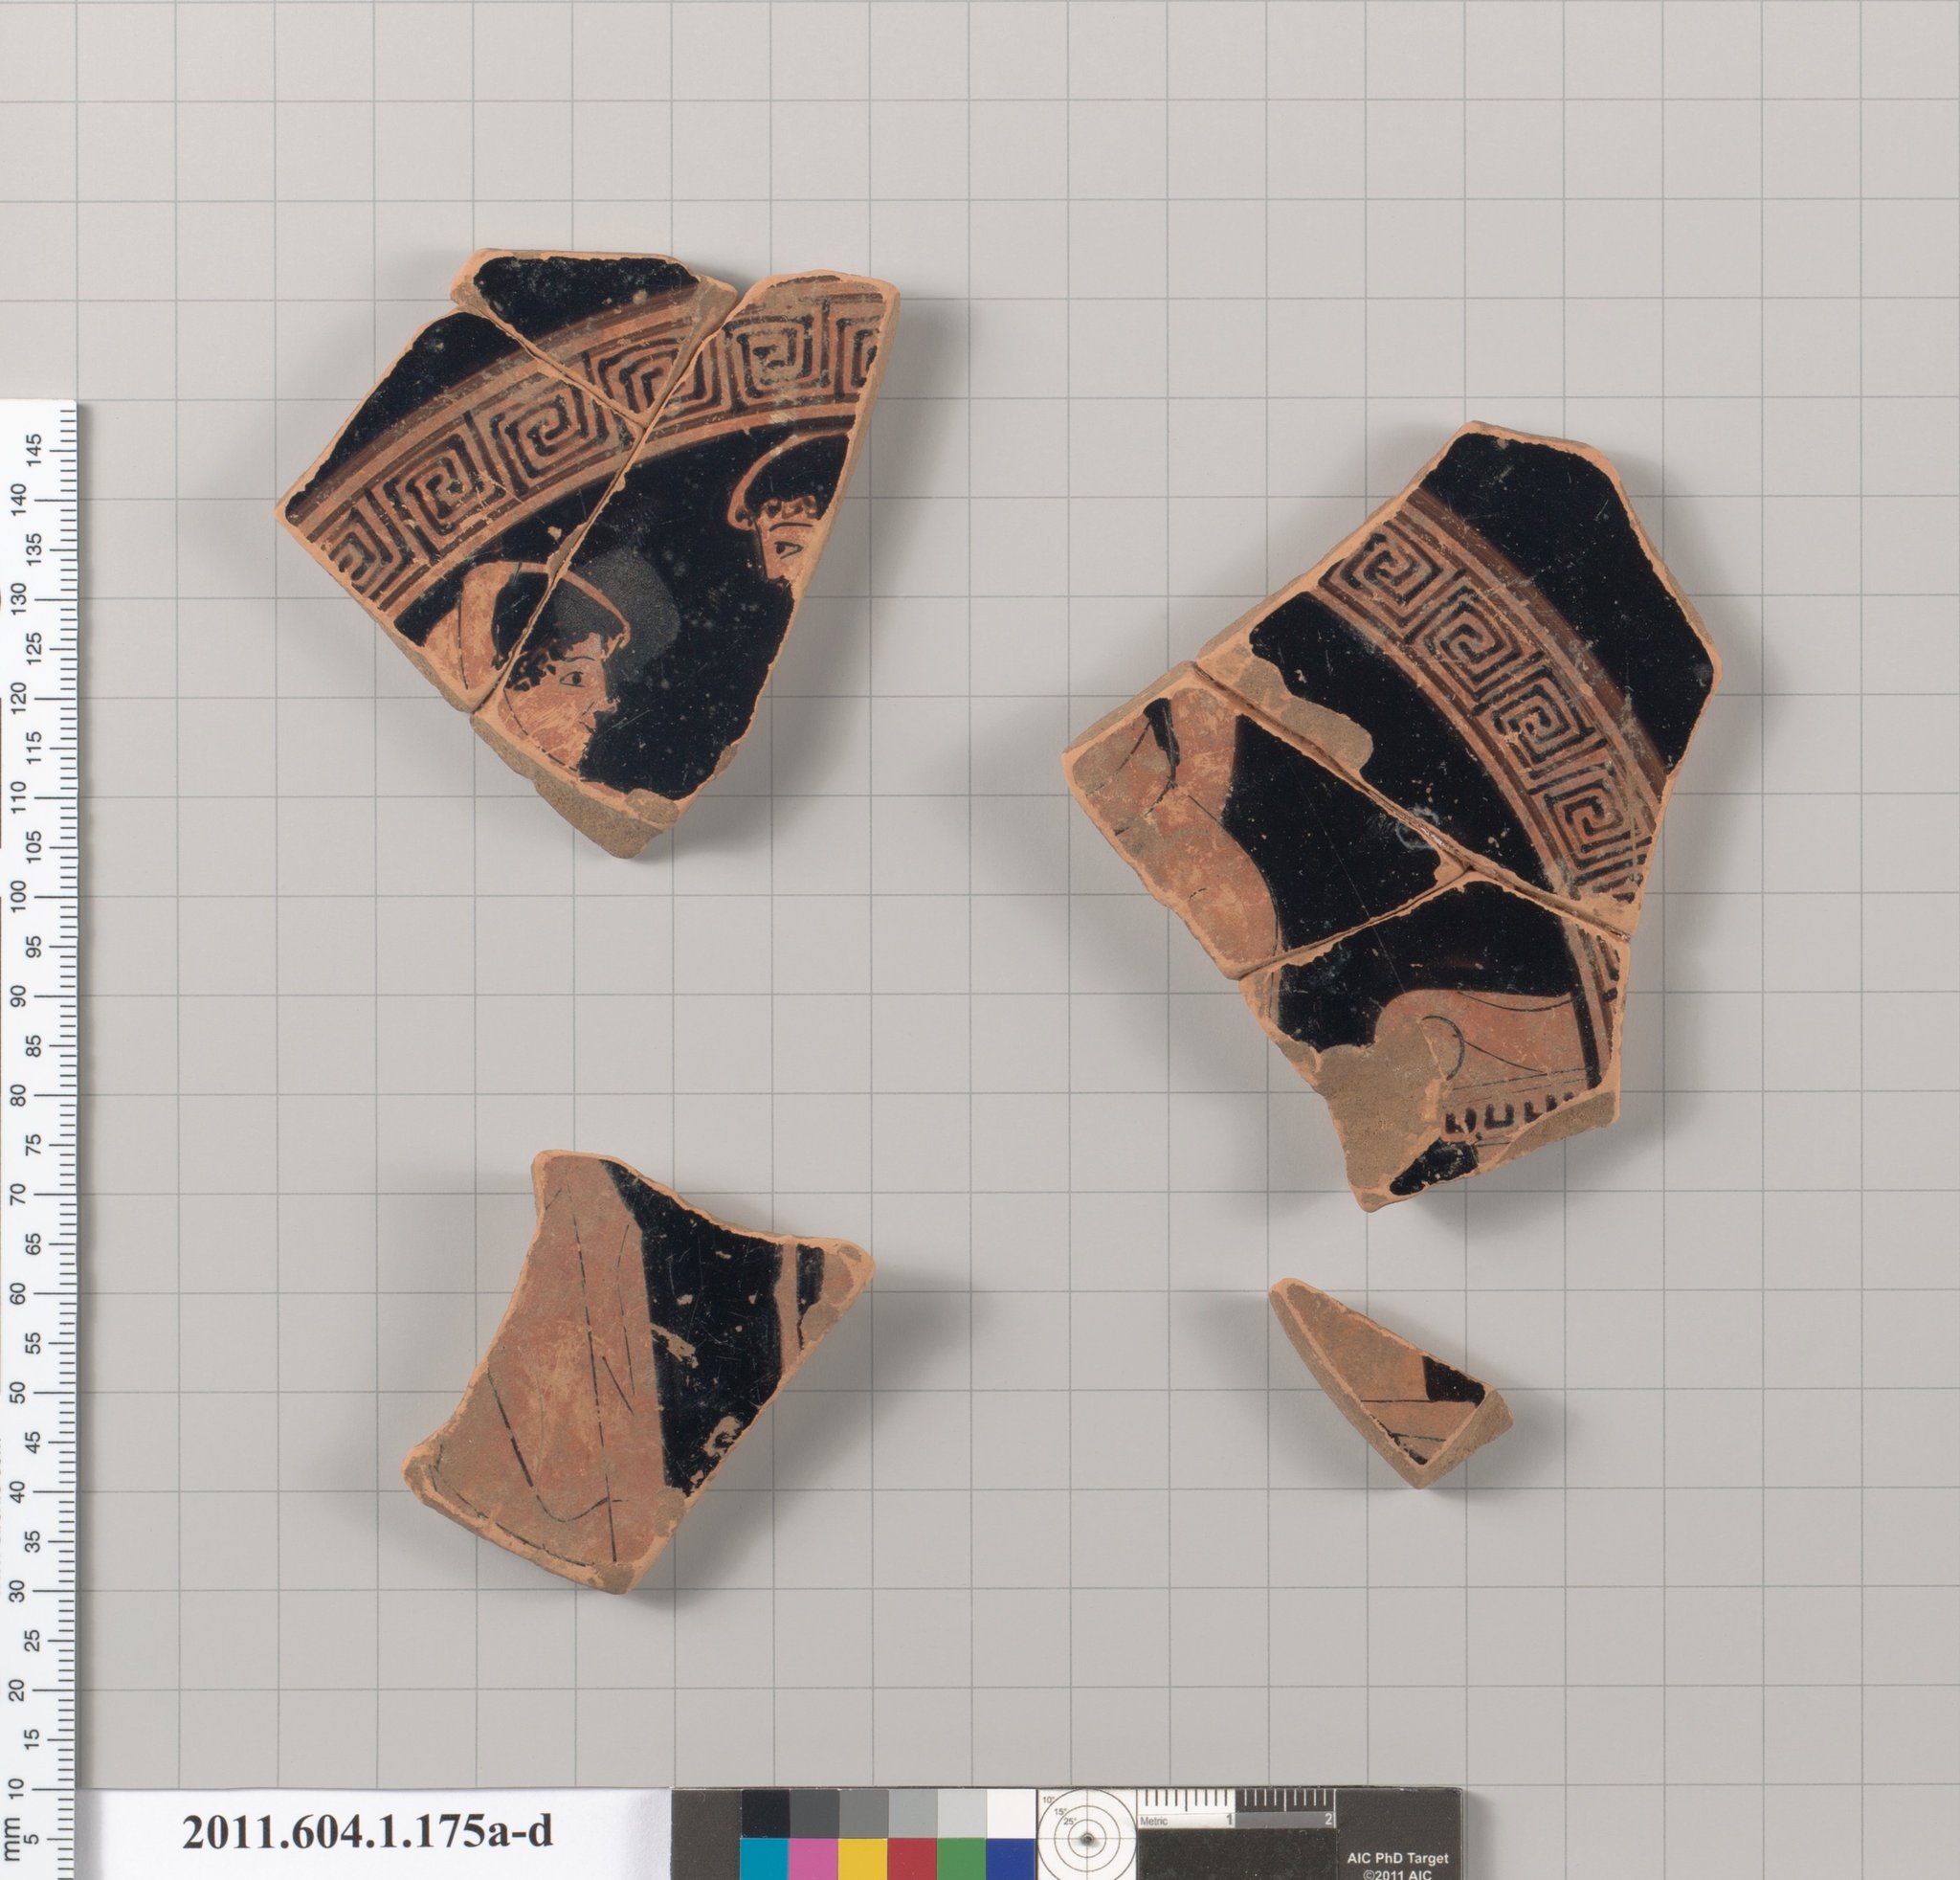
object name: kylix fragment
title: Terracotta fragments of a kylix (drinking cup)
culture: greek, attic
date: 475-451 BCE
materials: terracotta